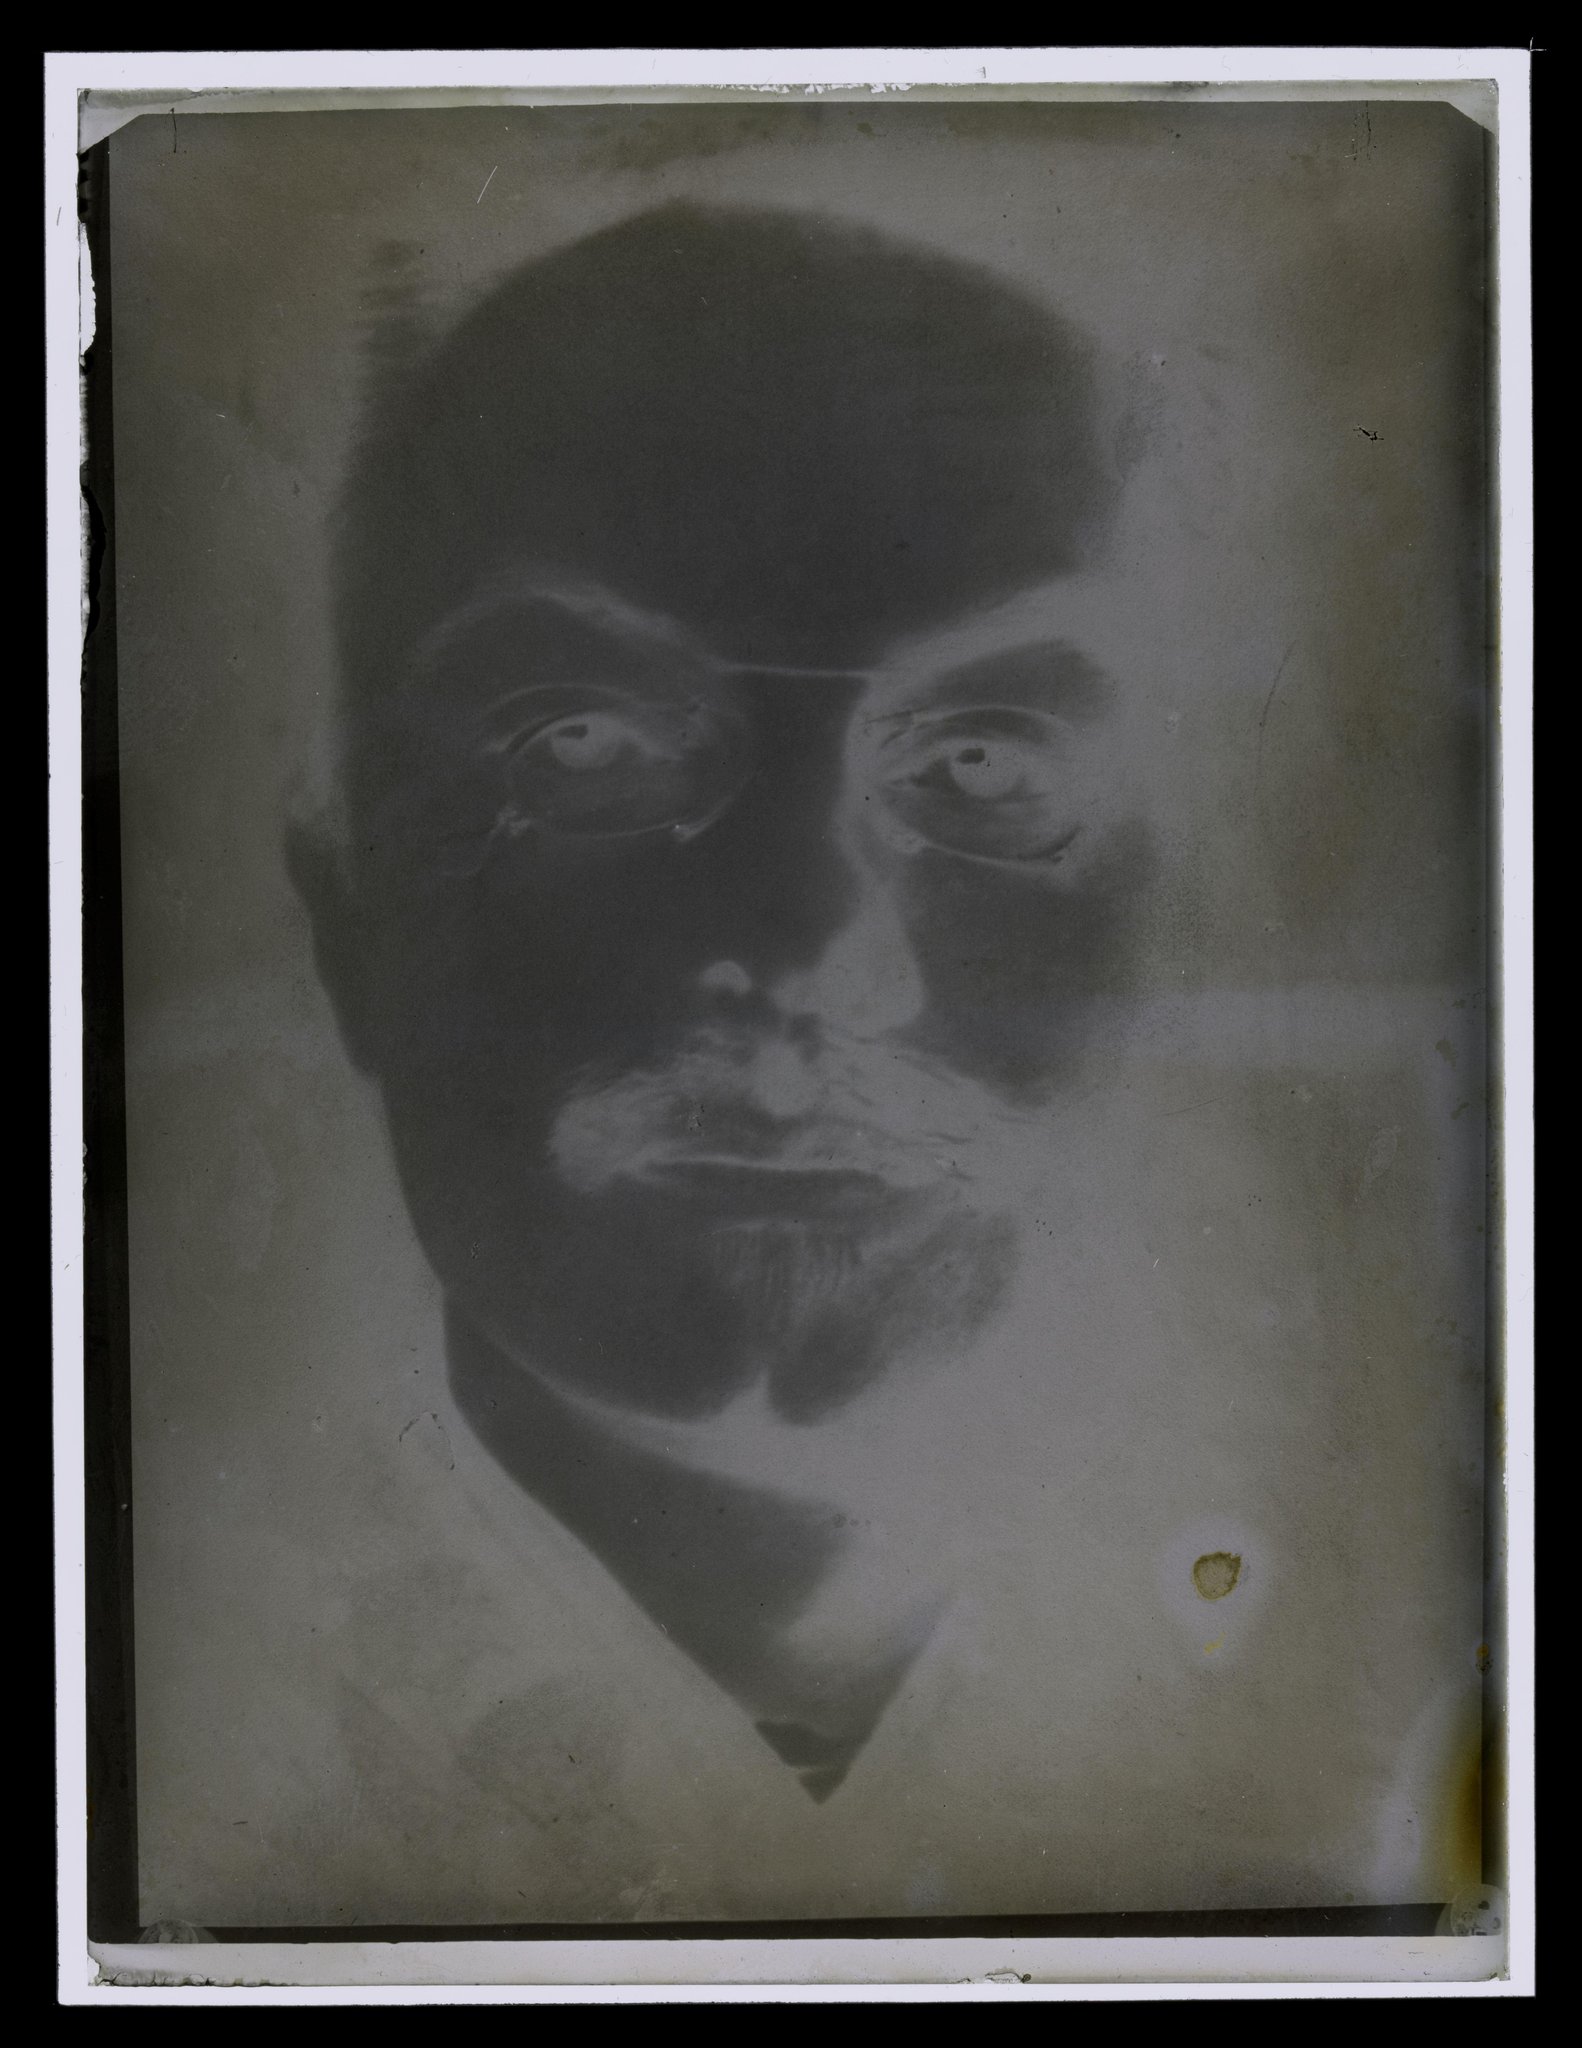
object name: glasnegatief, glasplaatnegatief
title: Portret van Alphons Diepenbrock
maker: wouterus gijsbertus hondius van den broek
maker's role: amateurfotograaf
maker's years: 1867-1913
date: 1900-1921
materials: glass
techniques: gelatin glass negative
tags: amsterdam, alphons diepenbrock, historical persons, portrait of composer